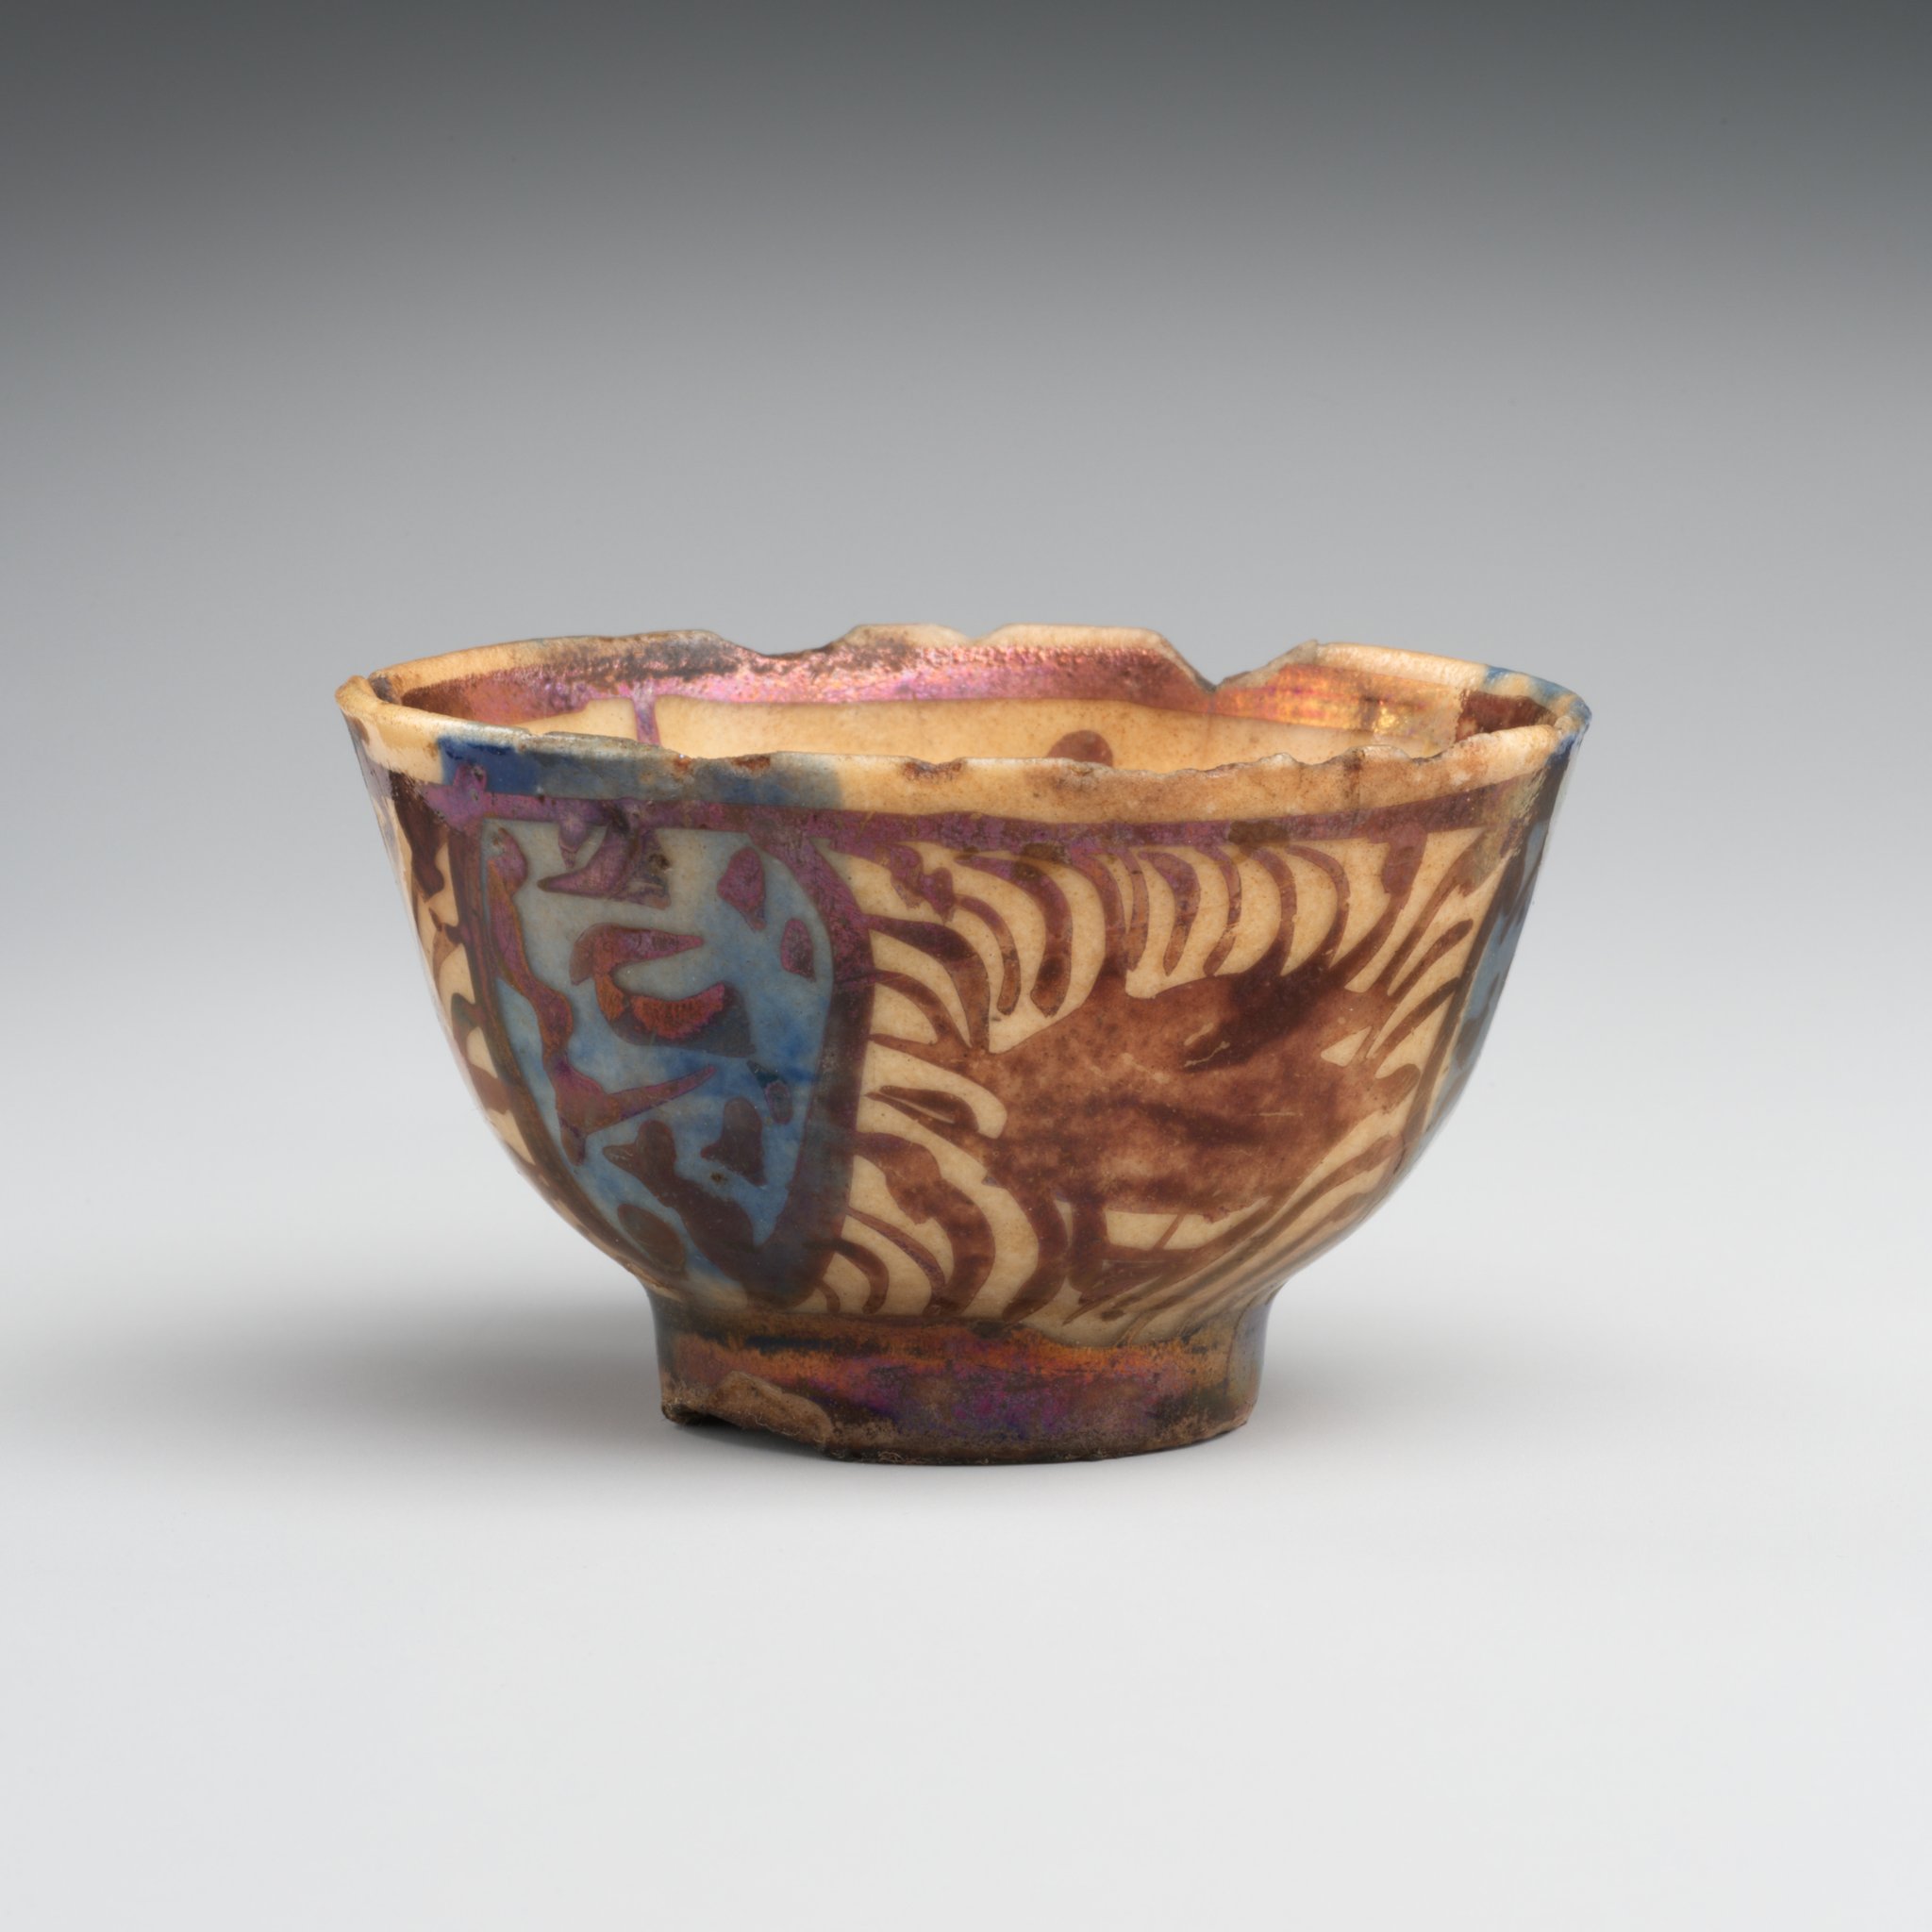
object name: cup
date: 1667-1800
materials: glaze, stonepaste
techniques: luster painting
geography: iran